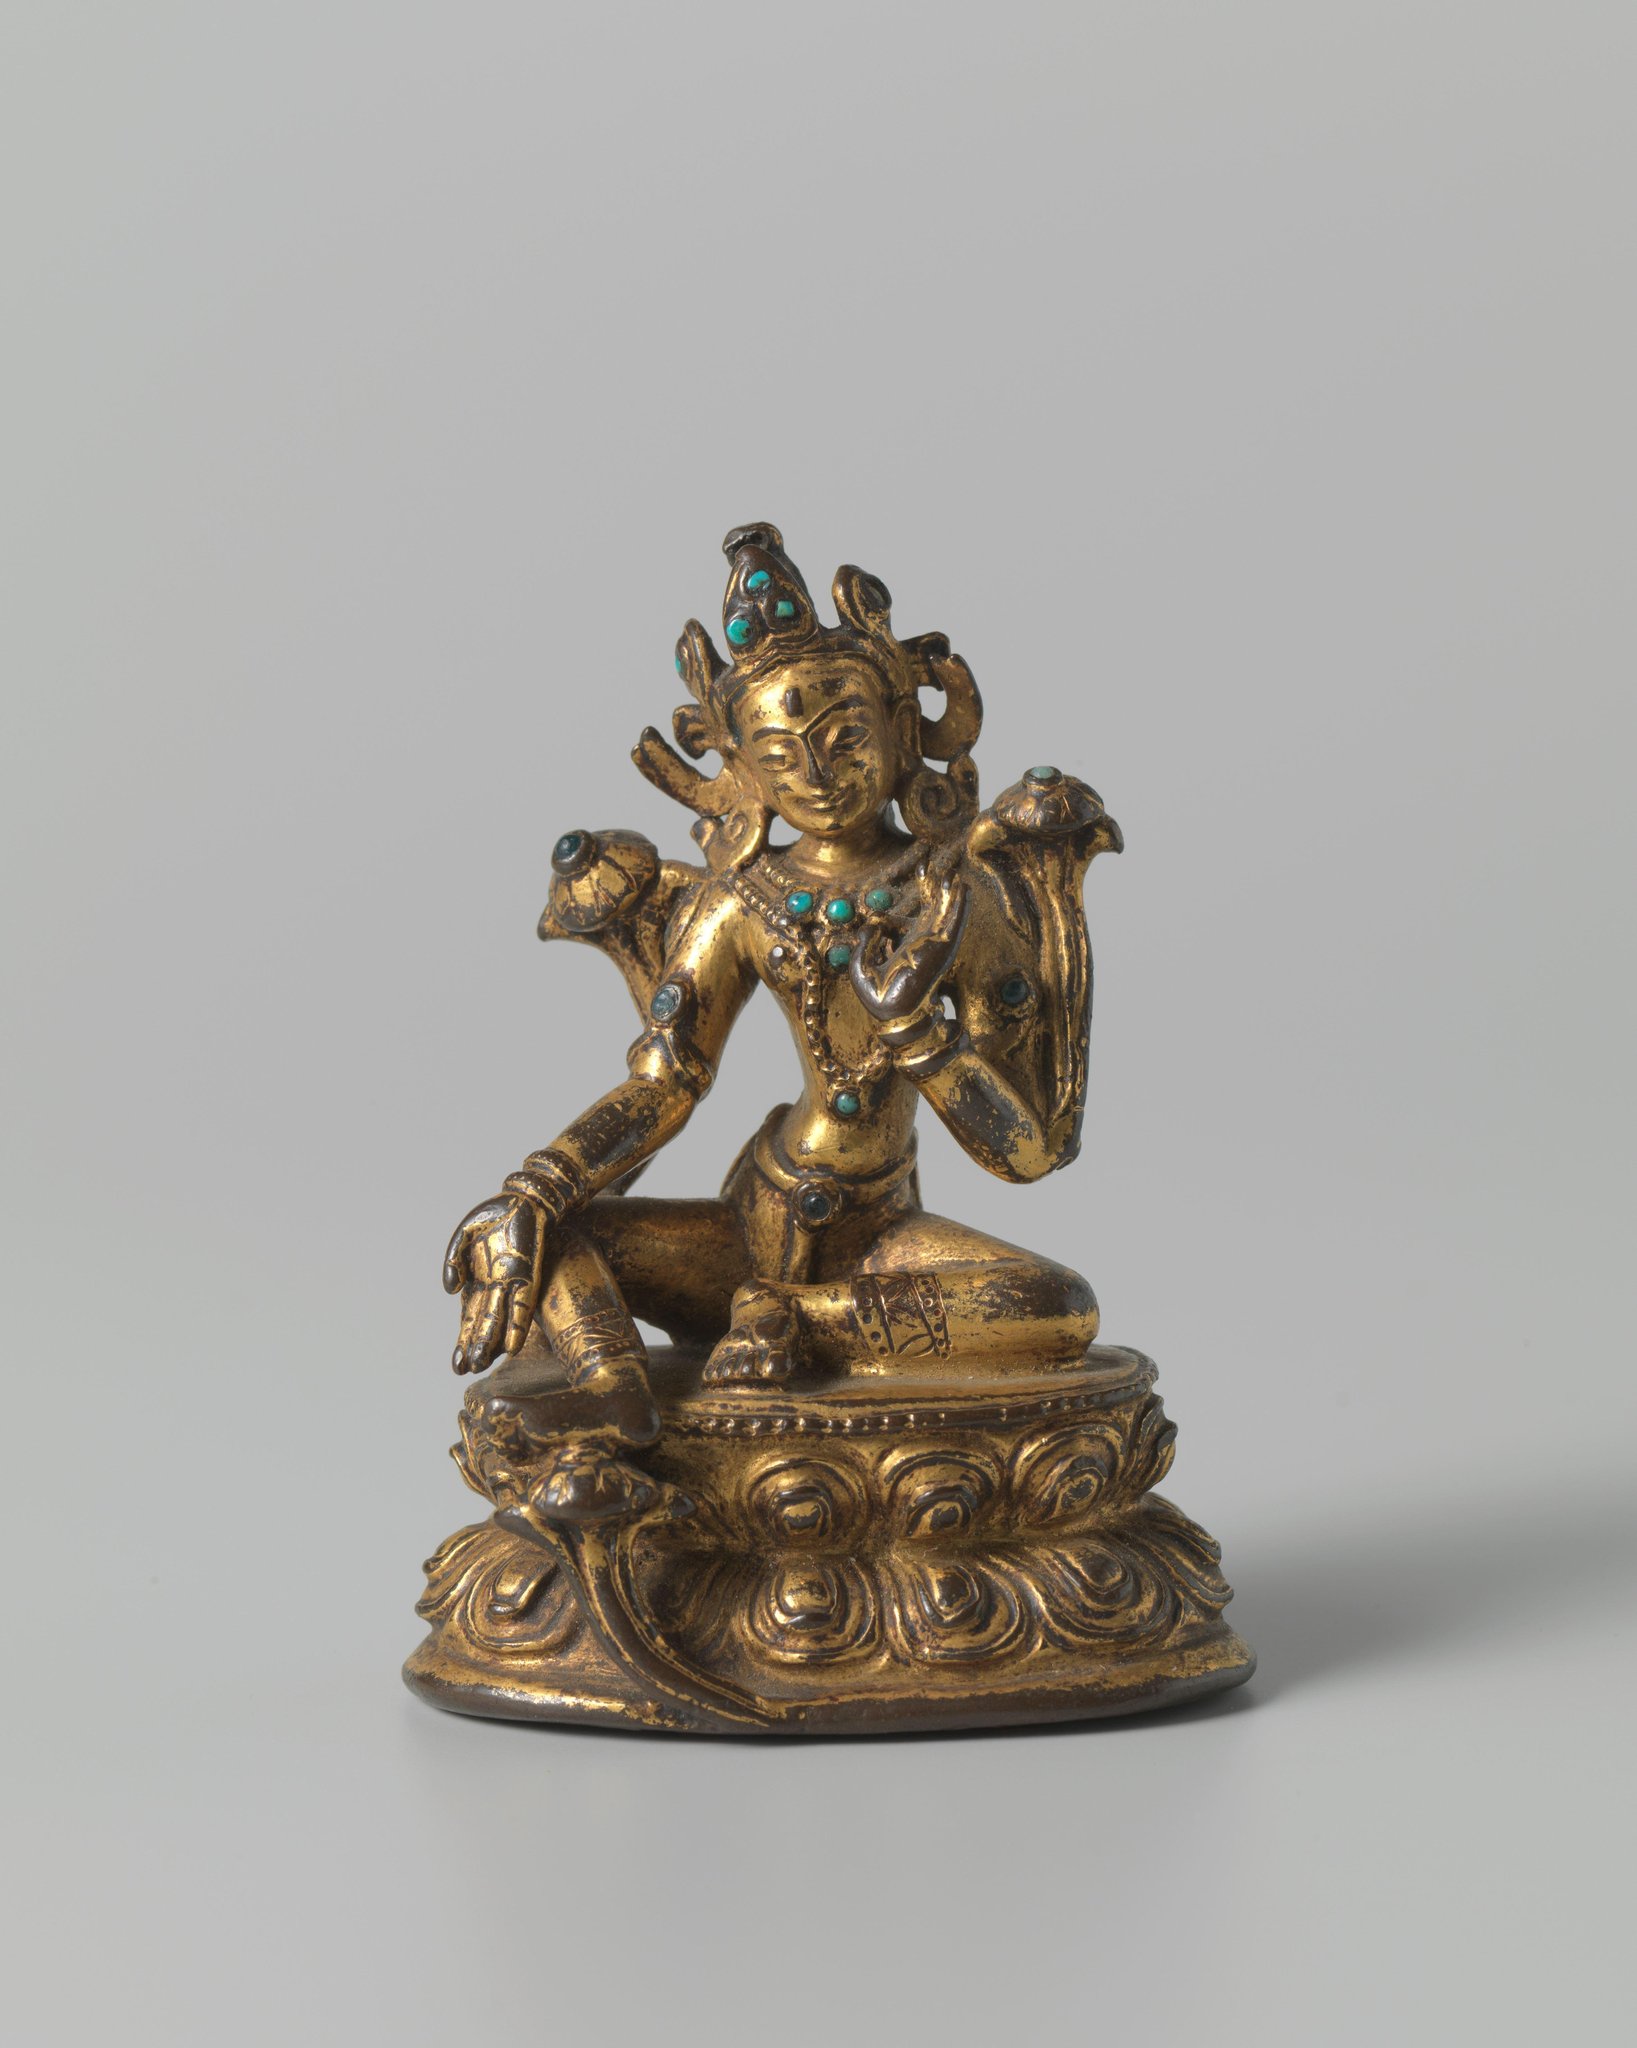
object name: figure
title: Tara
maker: Anonymous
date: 1700-1800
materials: bronze, gemstone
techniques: gilding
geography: tibet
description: Groene Tara, zittend, rechterbeen hangt naar beneden en steunt op een lotus.